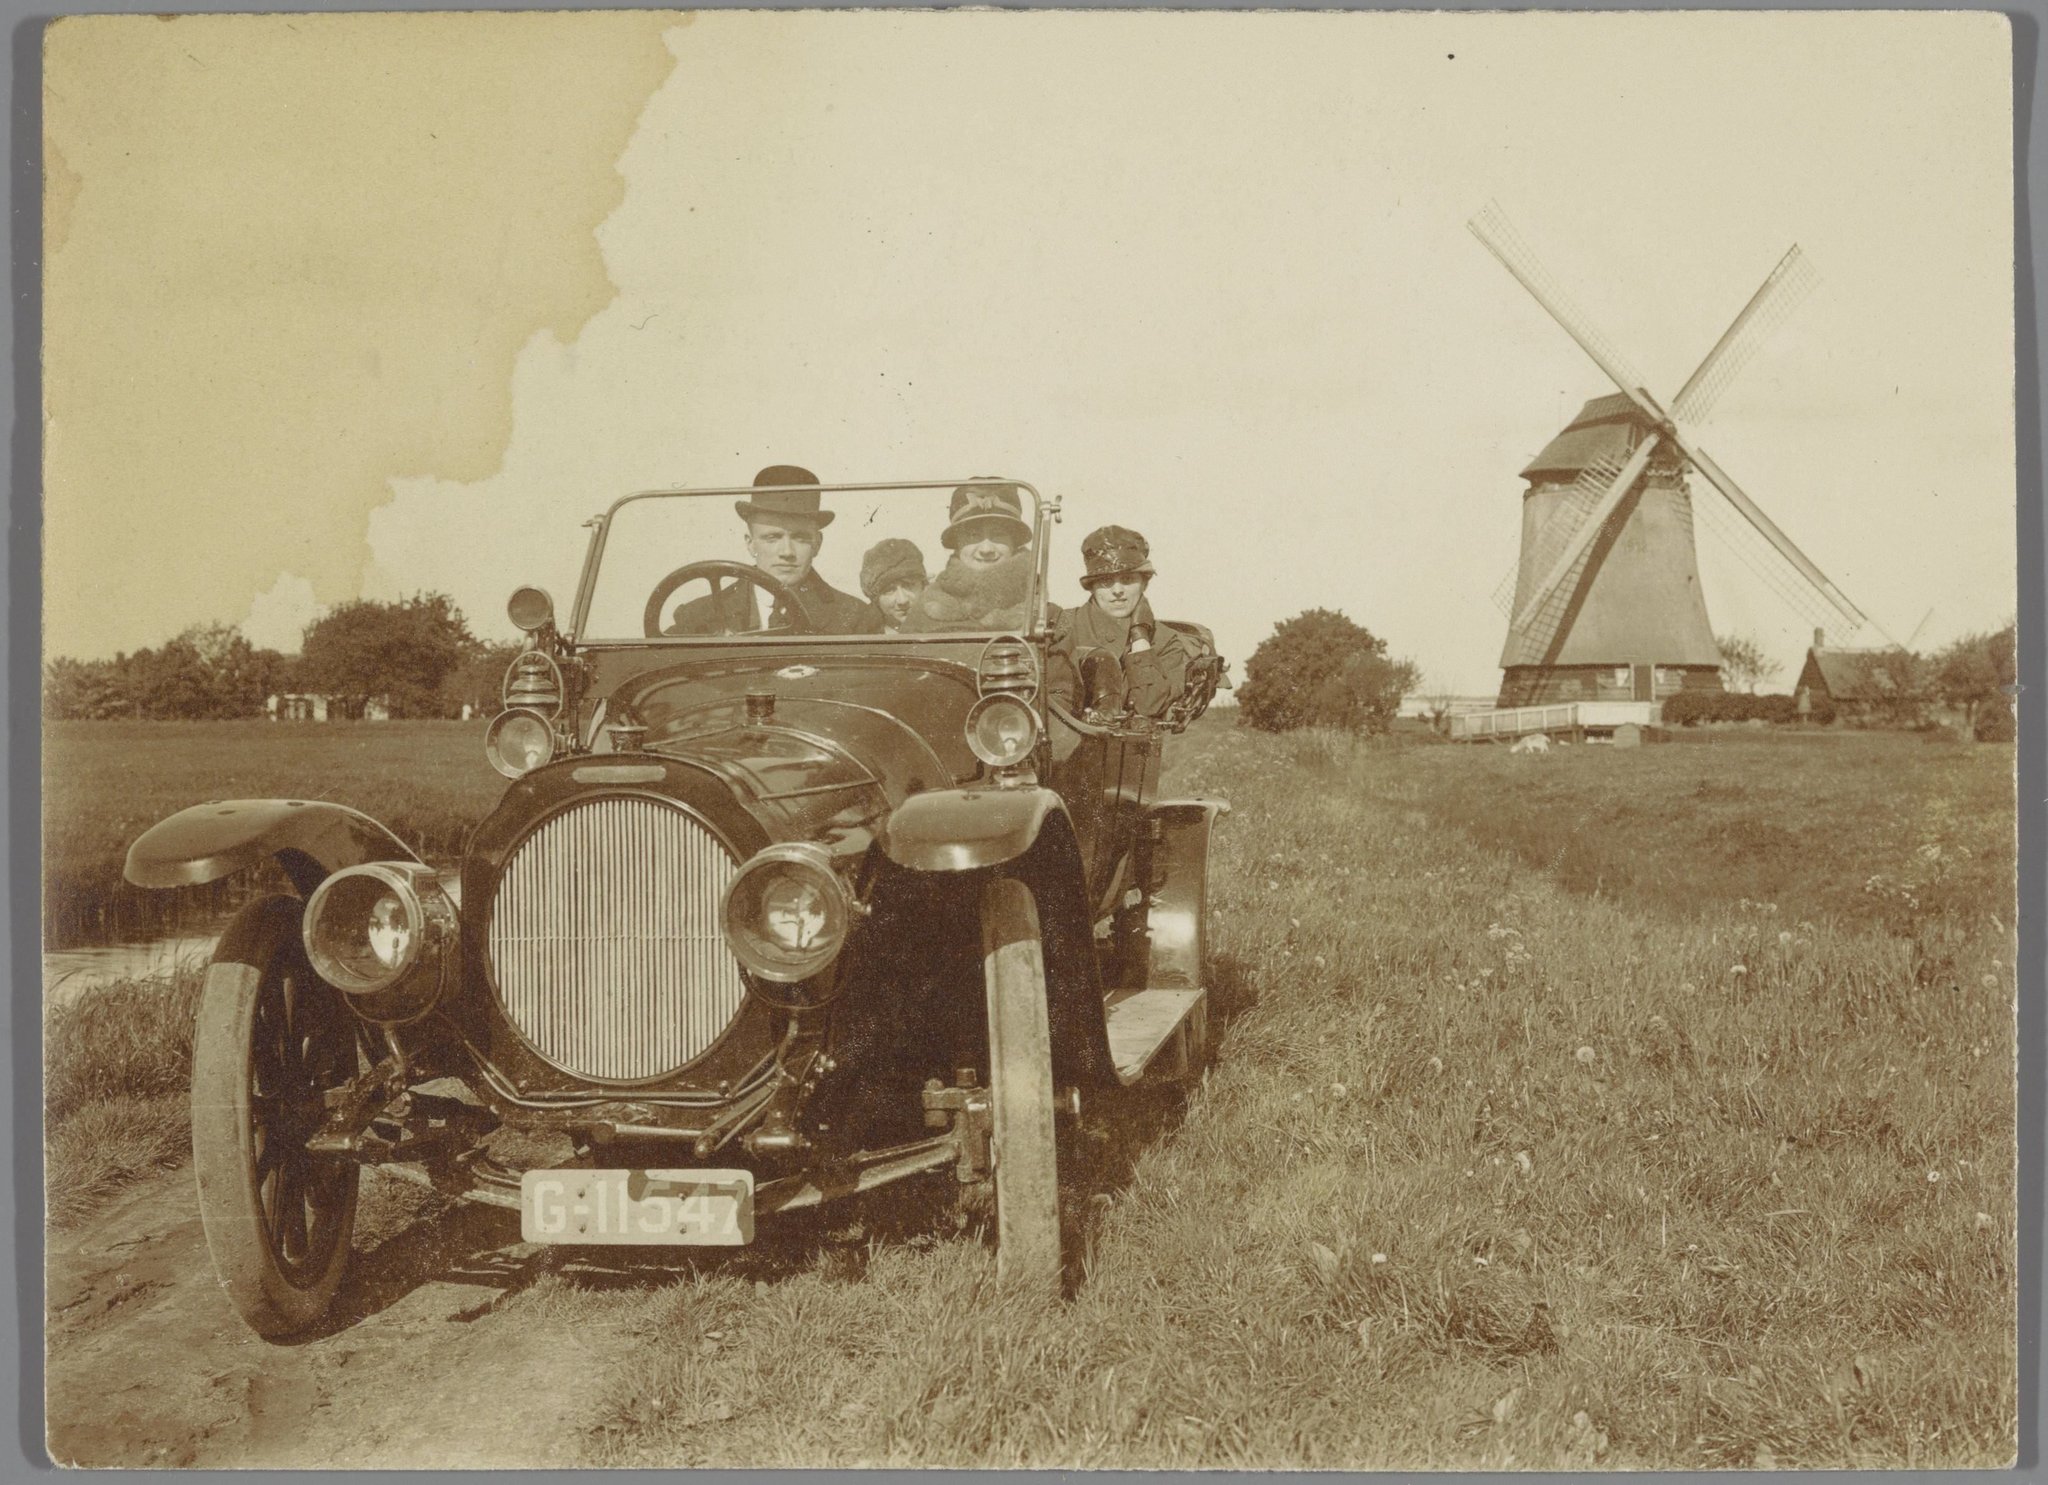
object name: photograph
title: Groep passagiers in een auto met op de achtergrond de Voorste Molen in Kortenhoef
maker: Anonymous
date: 1920-1935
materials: paper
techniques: gelatin silver print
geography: kortenhoef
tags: automobile, windmill